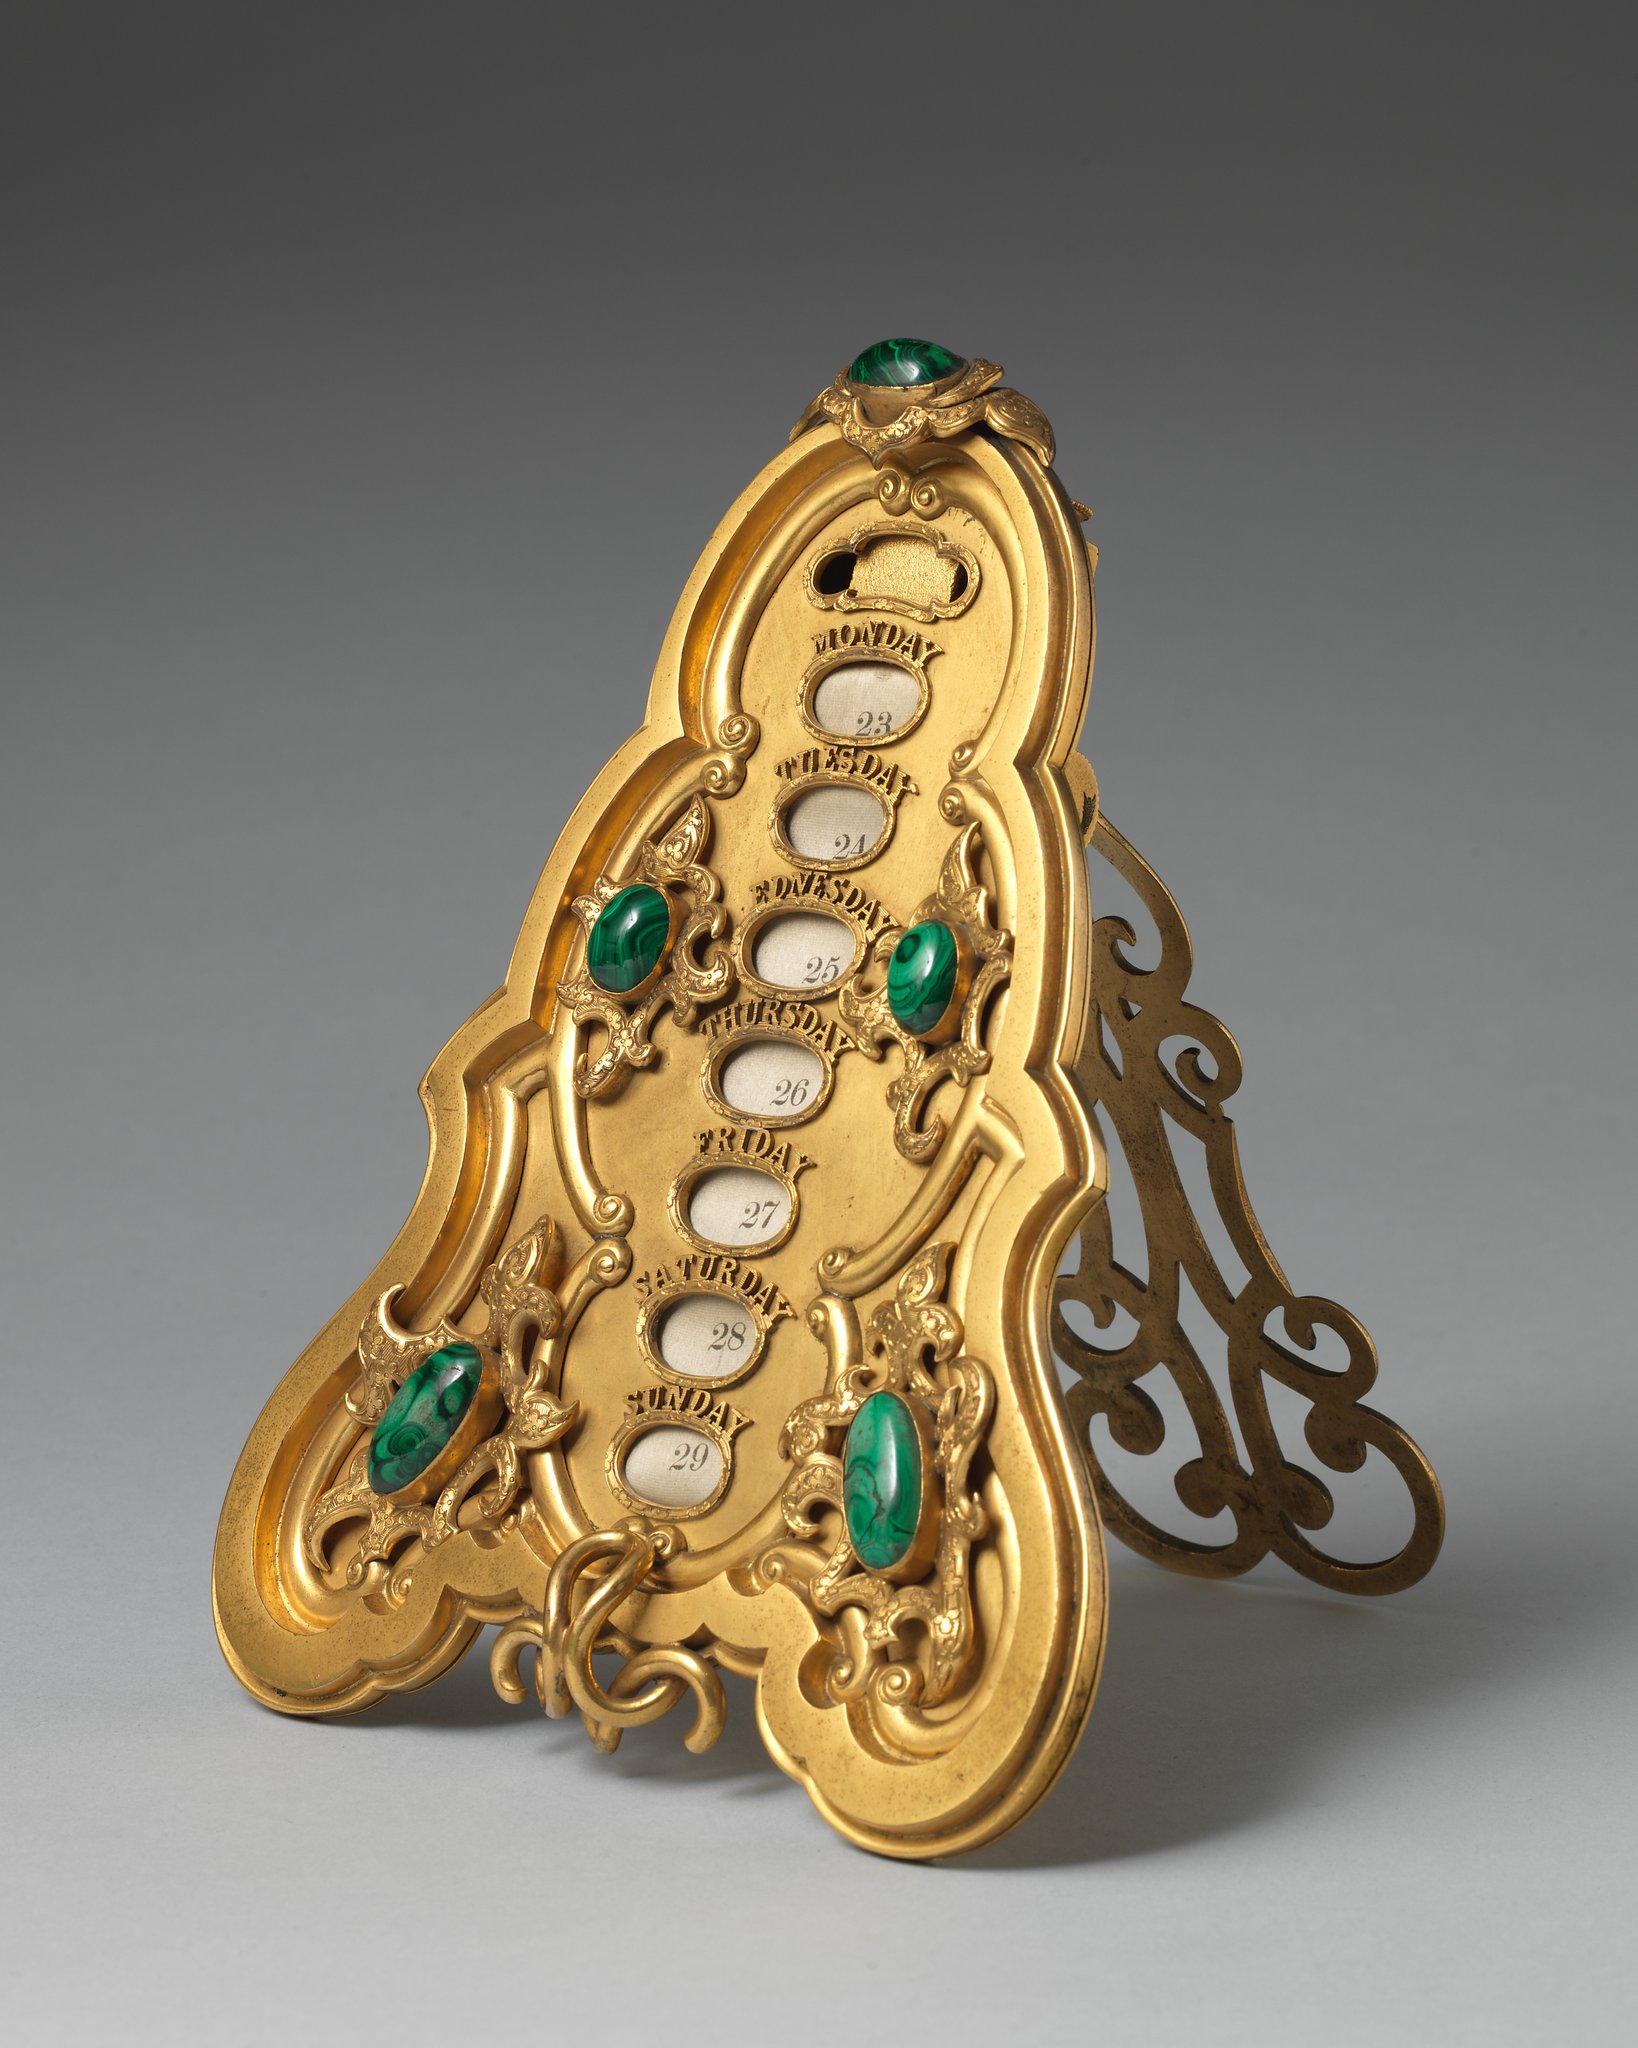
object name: calendar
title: Calendar (part of a set)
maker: asprey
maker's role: purveyor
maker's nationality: british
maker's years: 1781-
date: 1851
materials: gilt bronze